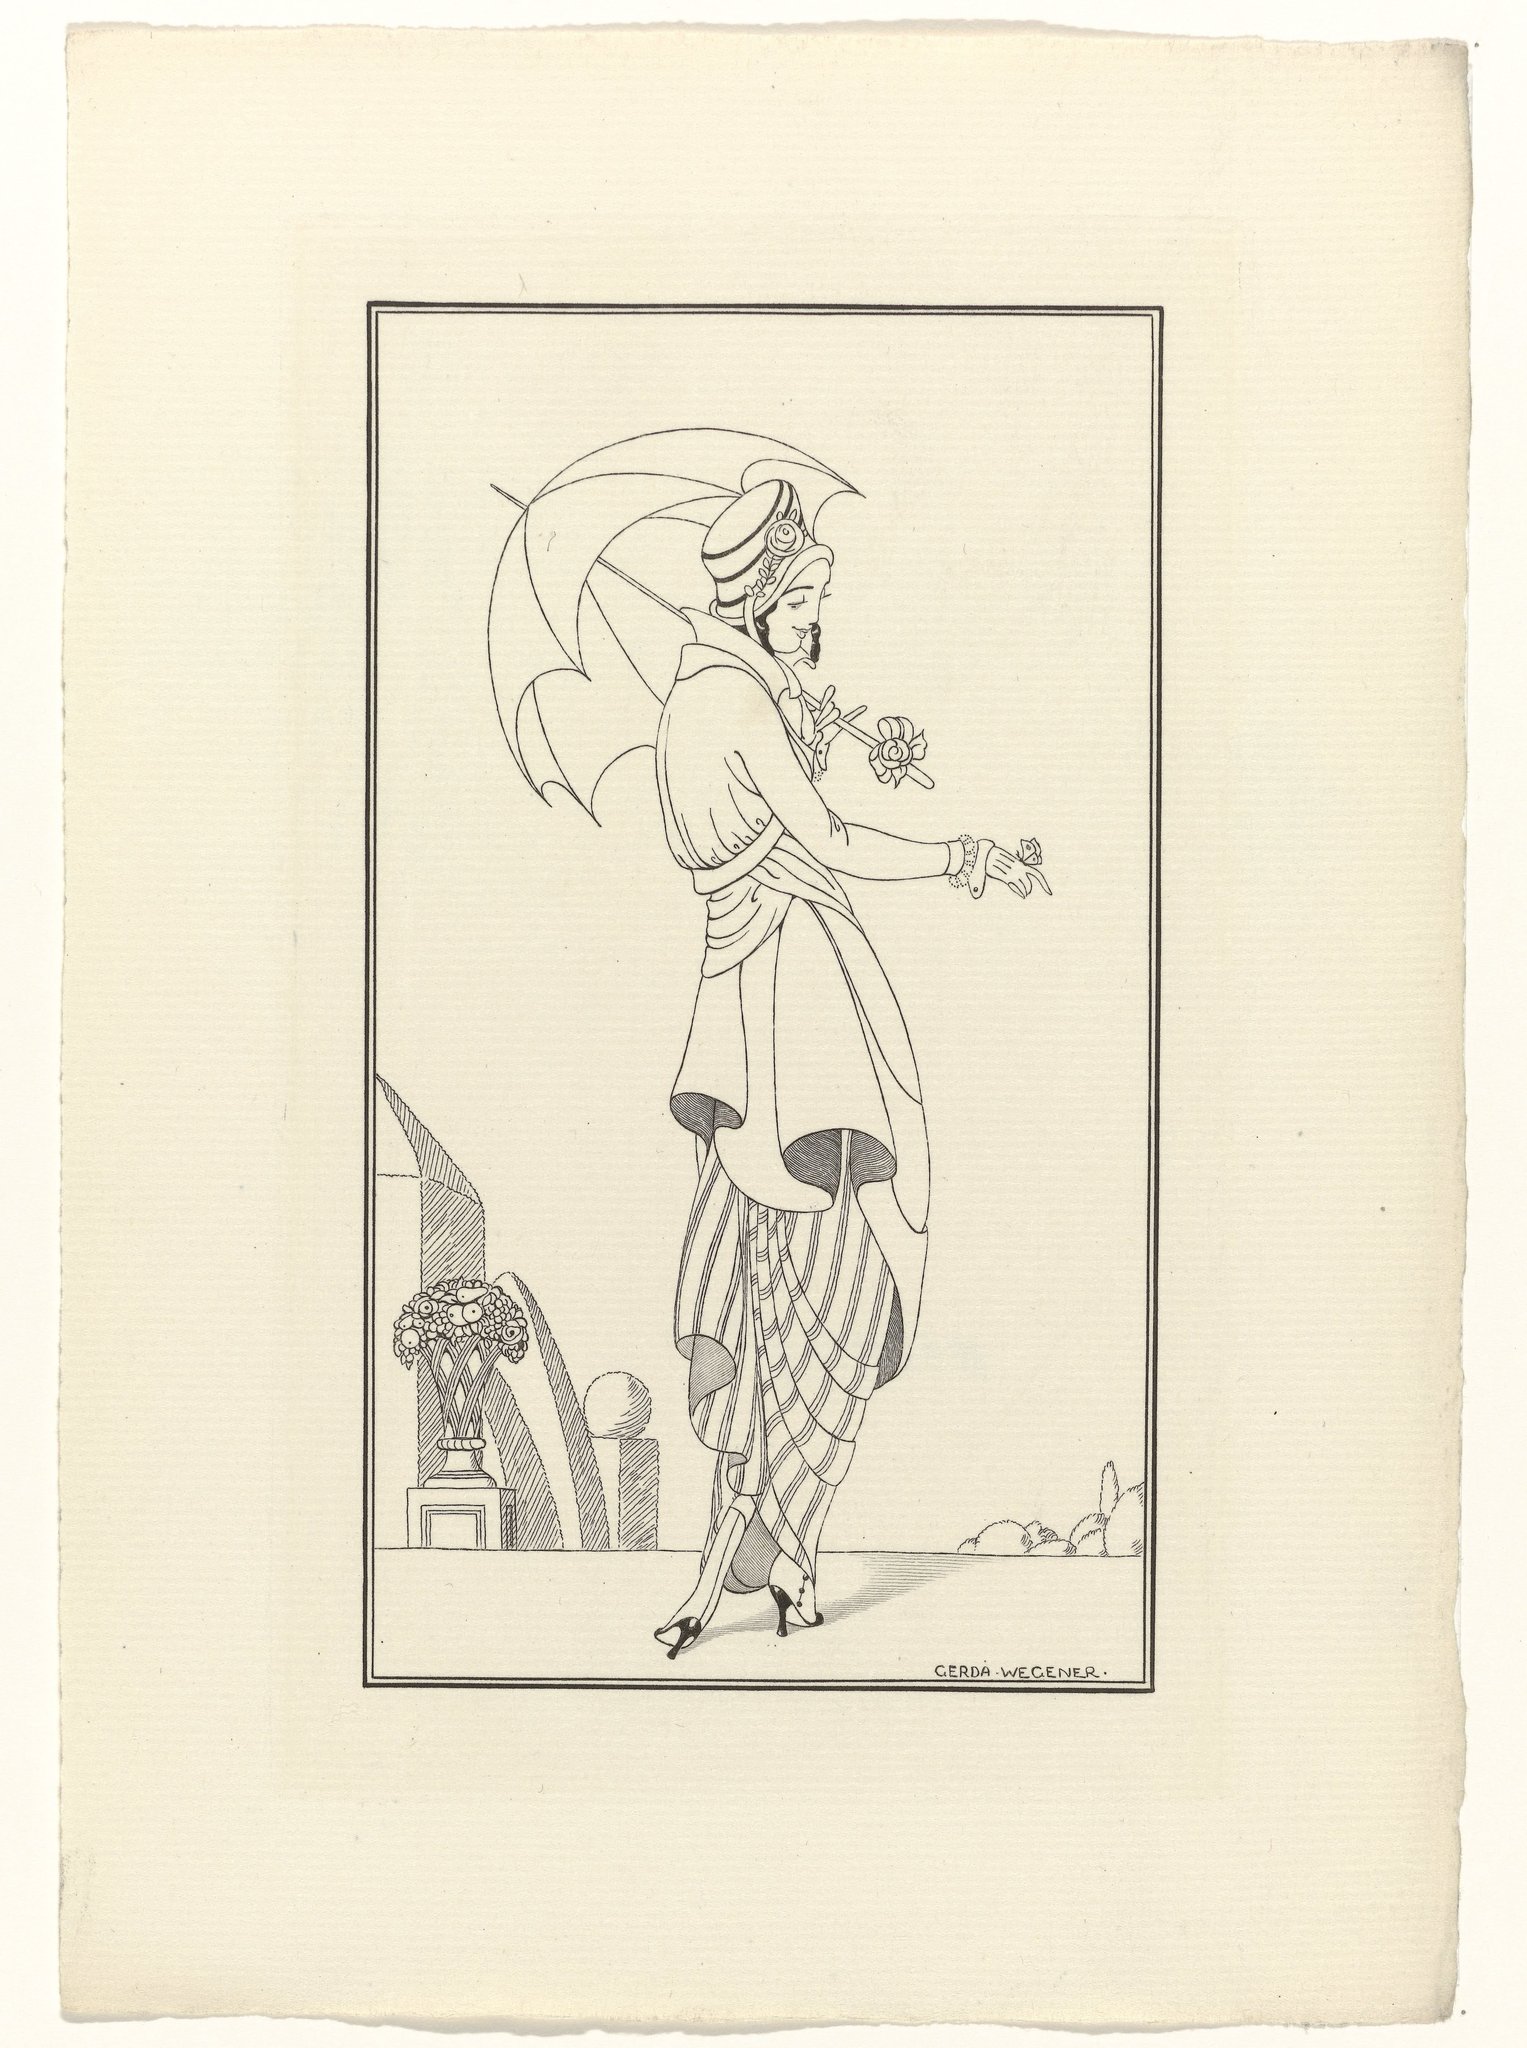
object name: fashion print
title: Journal des Dames et des Modes, Costumes Parisiens, 1914, No. 158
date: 1914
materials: paper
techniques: engraving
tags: umbrella (+ women's clothes), fashion plates, head-gear: hat (+ women's clothes), dress, gown (+ women's clothes), insects: butterfly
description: Japon waarvan de rok achter is opgenomen. Parasol. Proefdruk van een prent uit het modetijdschrift Journal des Dames et des Modes (1912-1914).